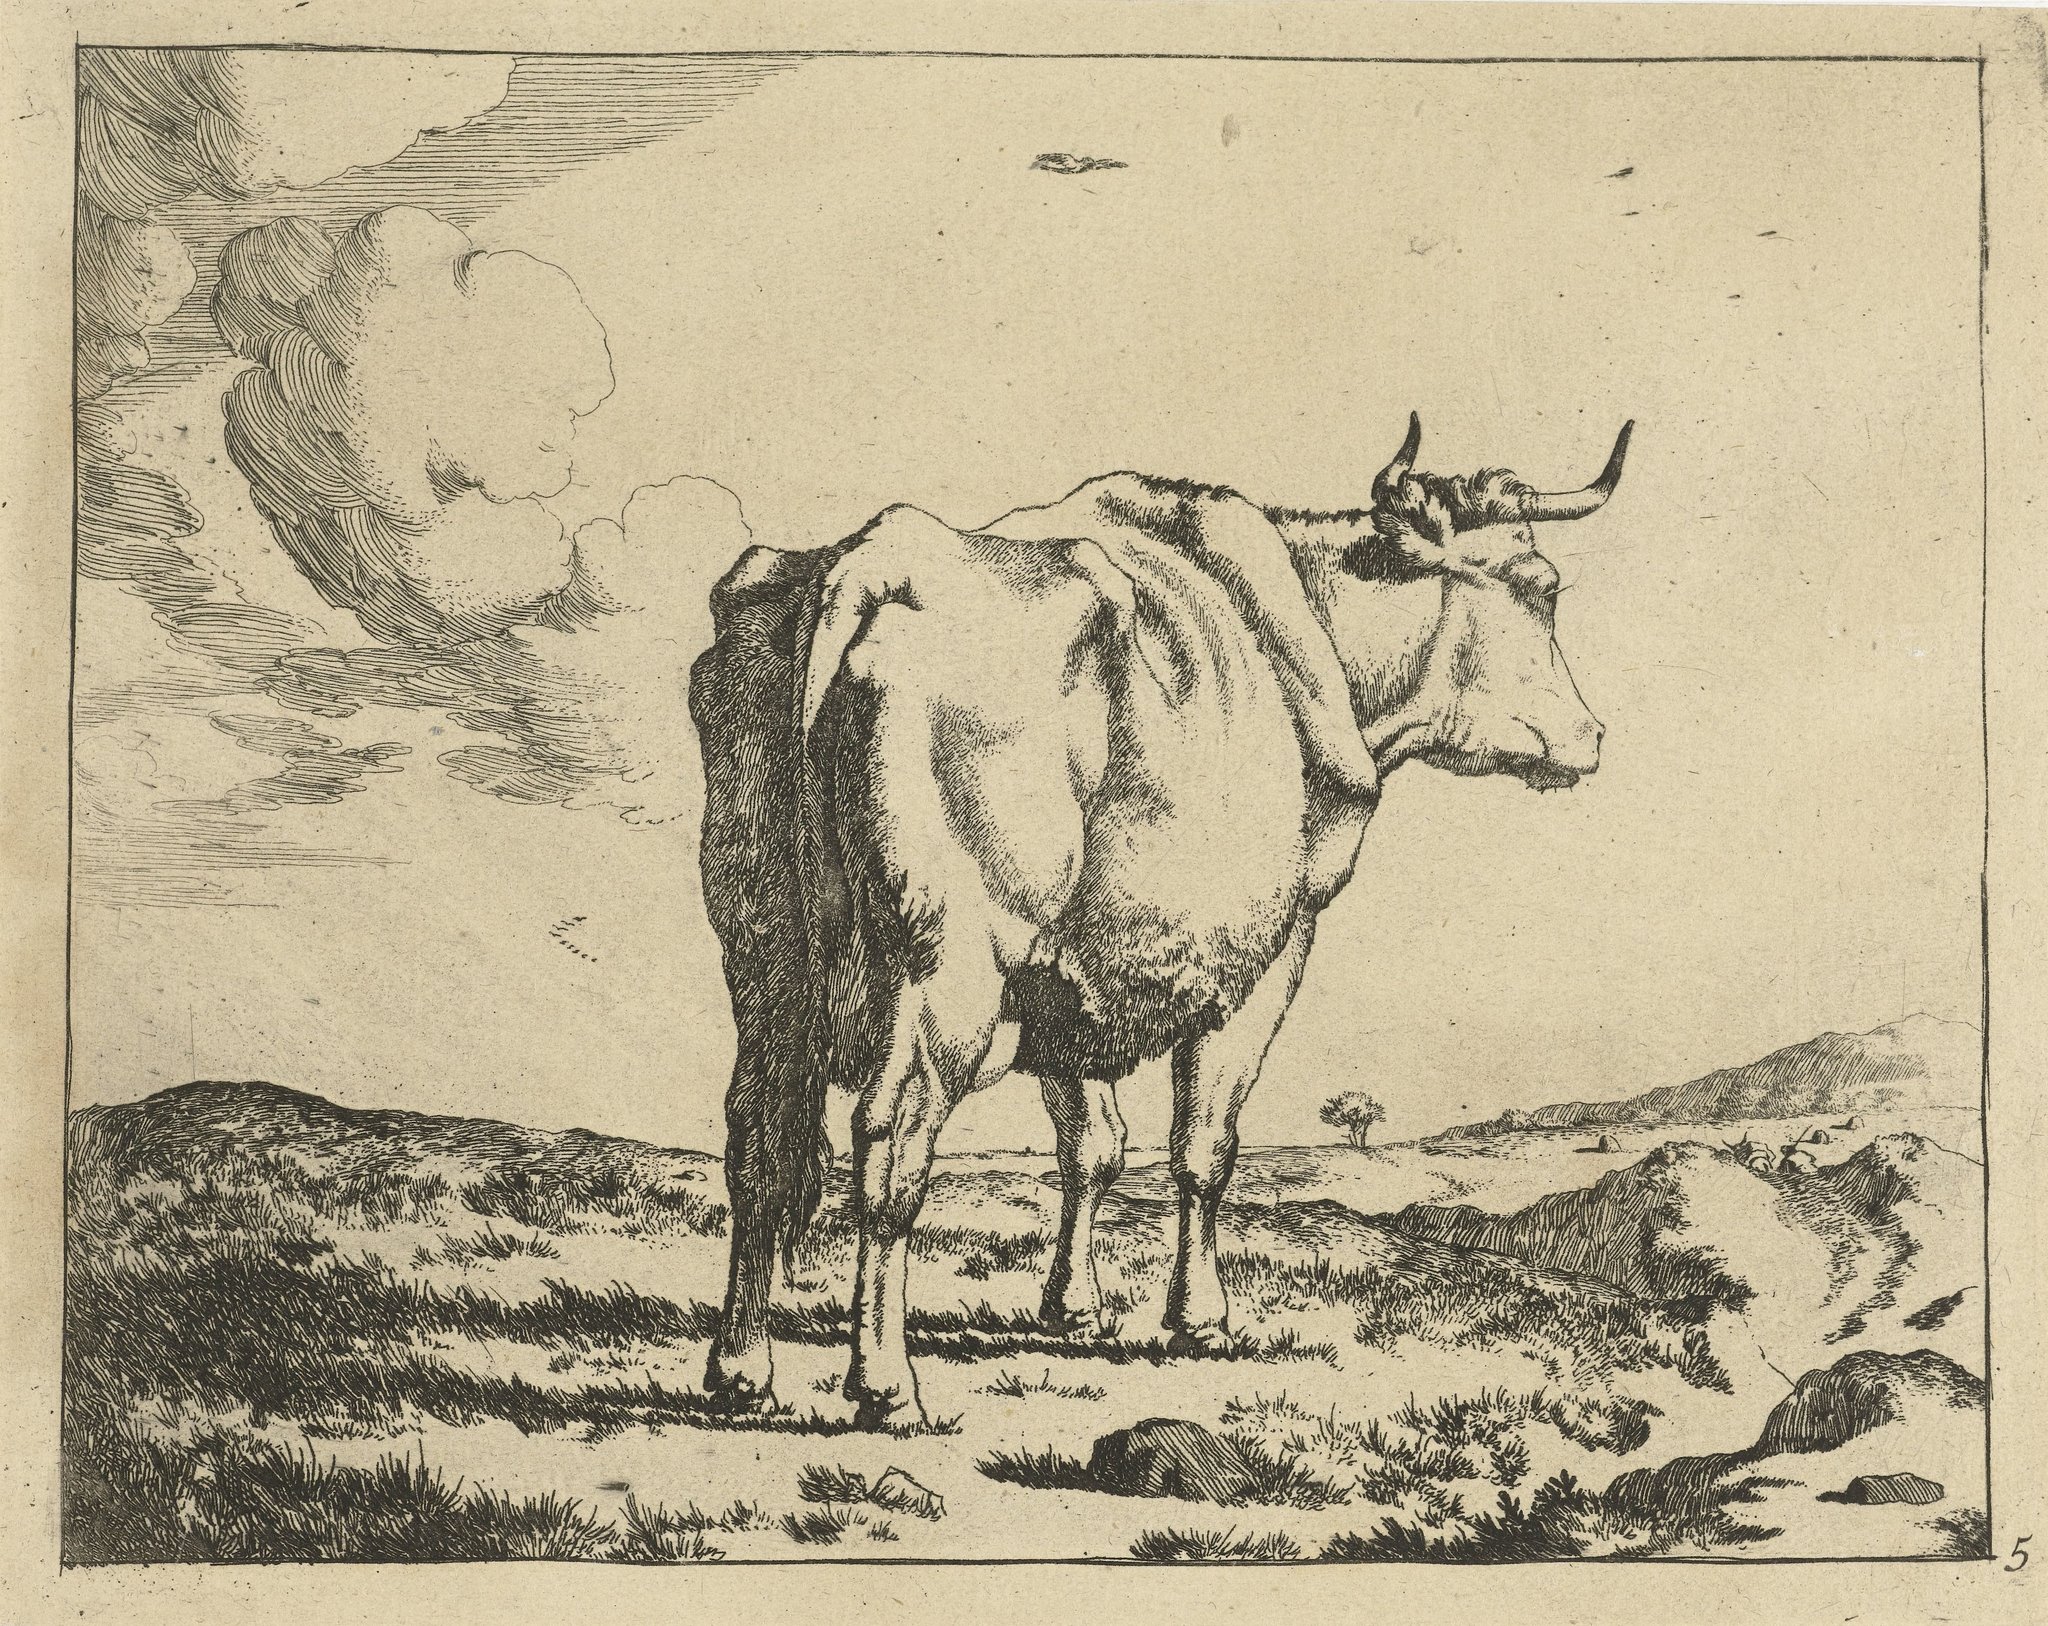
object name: print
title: Runderen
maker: marcus de bye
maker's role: print maker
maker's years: 1639-1688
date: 1657-1677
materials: paper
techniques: etching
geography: the hague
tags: cow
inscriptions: collector's mark: Lugt 2228